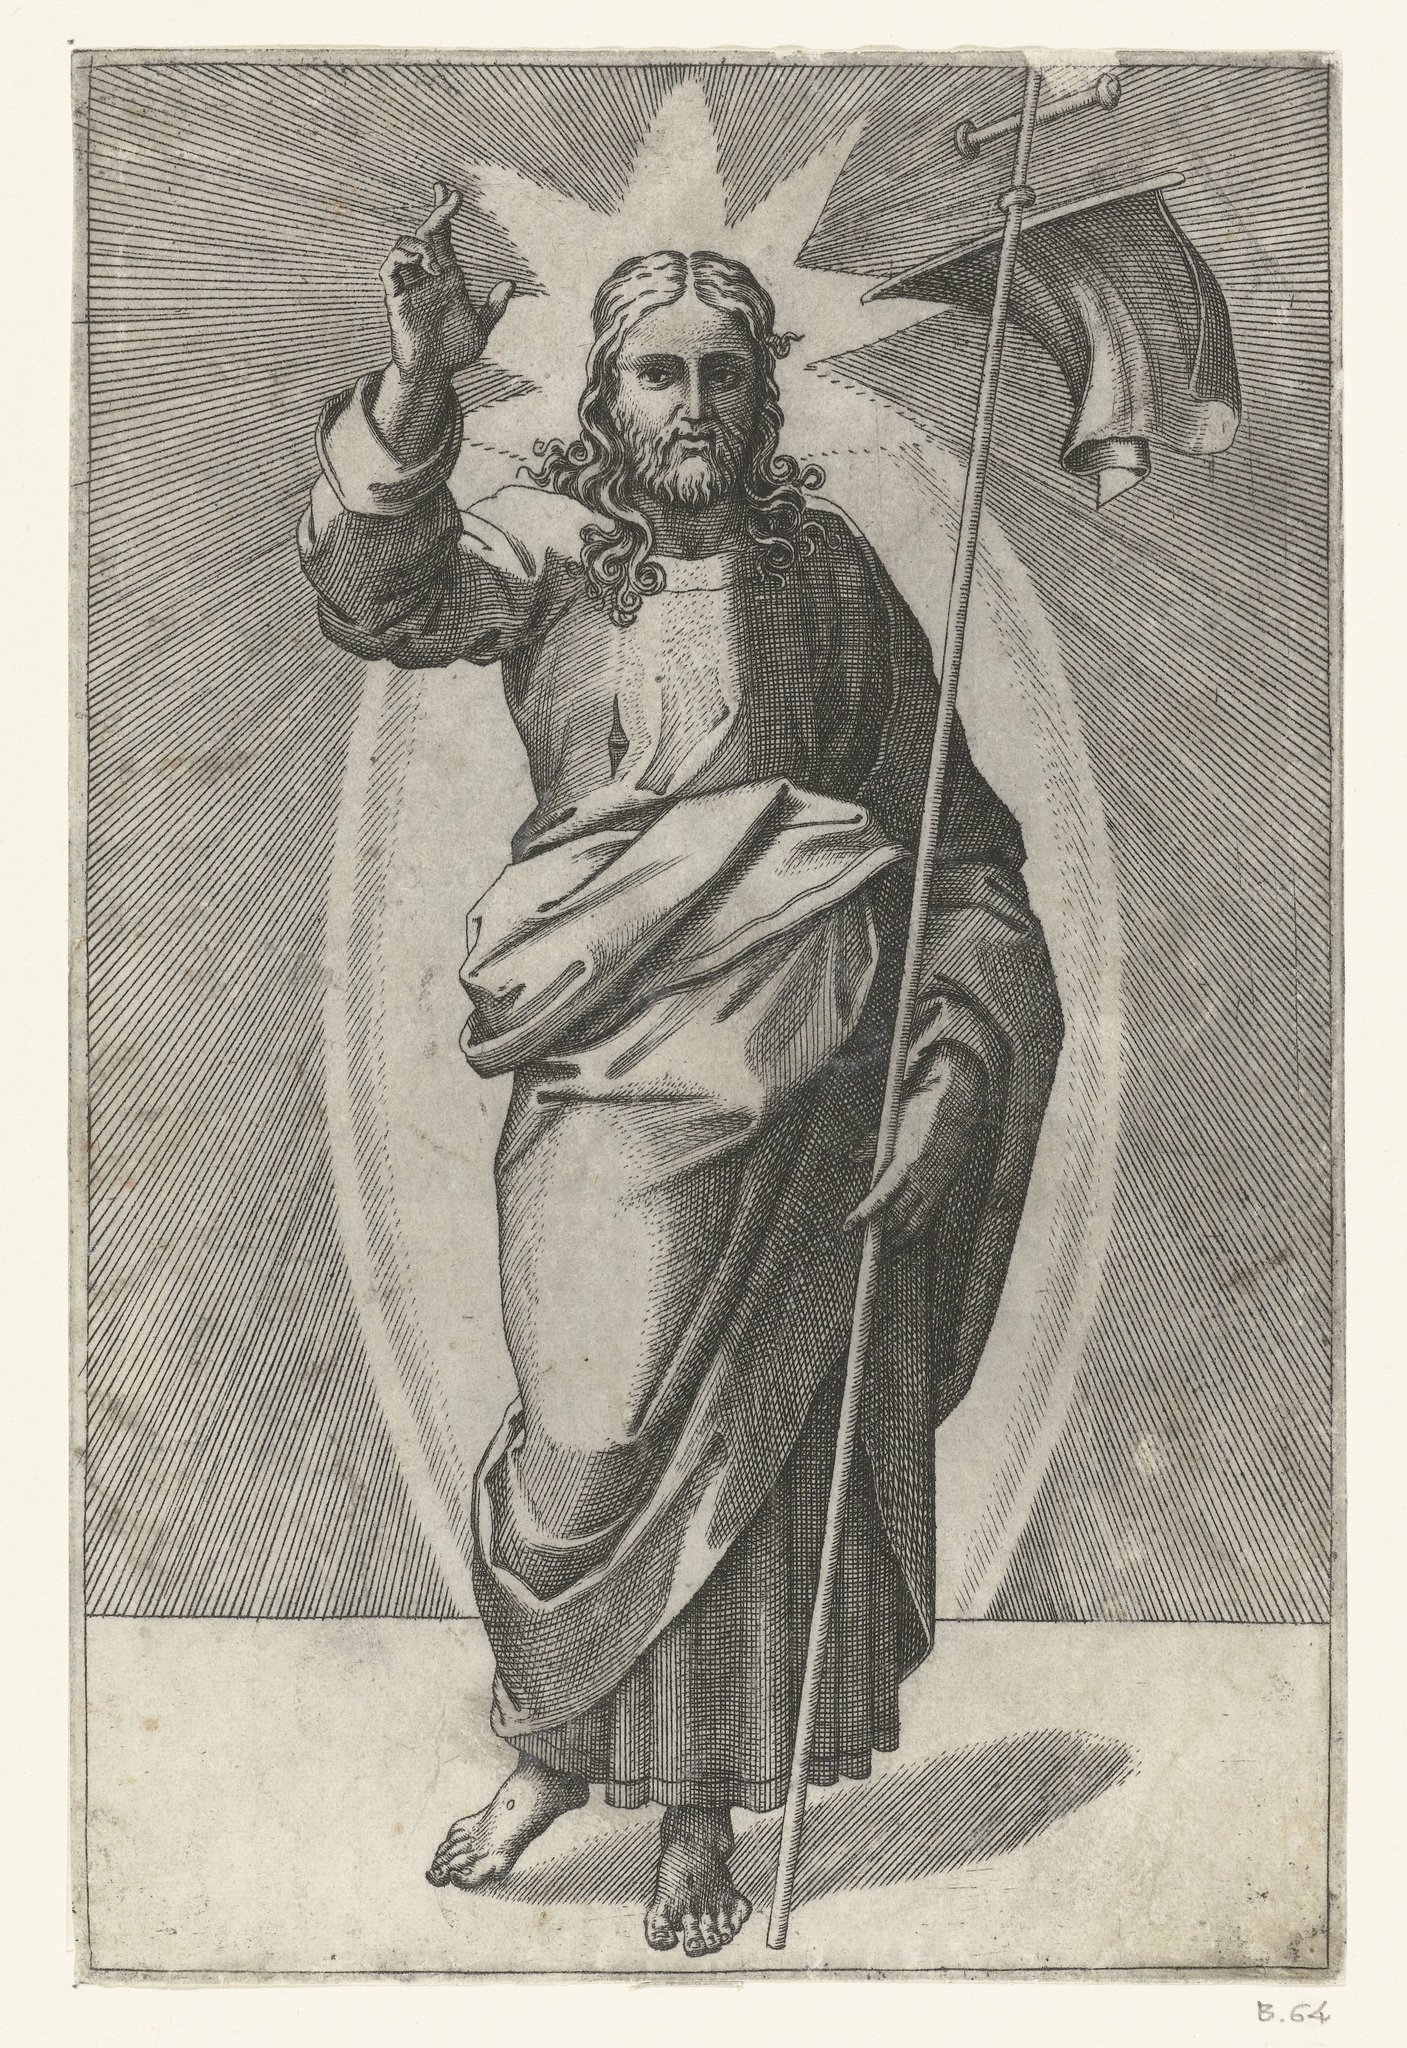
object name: print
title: Christus en de Apostelen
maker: marcantonio raimondi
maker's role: print maker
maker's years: 1470-1534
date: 1517-1527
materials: paper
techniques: engraving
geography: italy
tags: 'salvator mundi', making a blessing gesture; an orb in his hand or at his feet